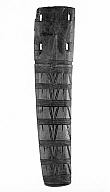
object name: finger grip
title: Sword Grip (?)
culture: punuk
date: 901-1000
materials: ivory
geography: united states